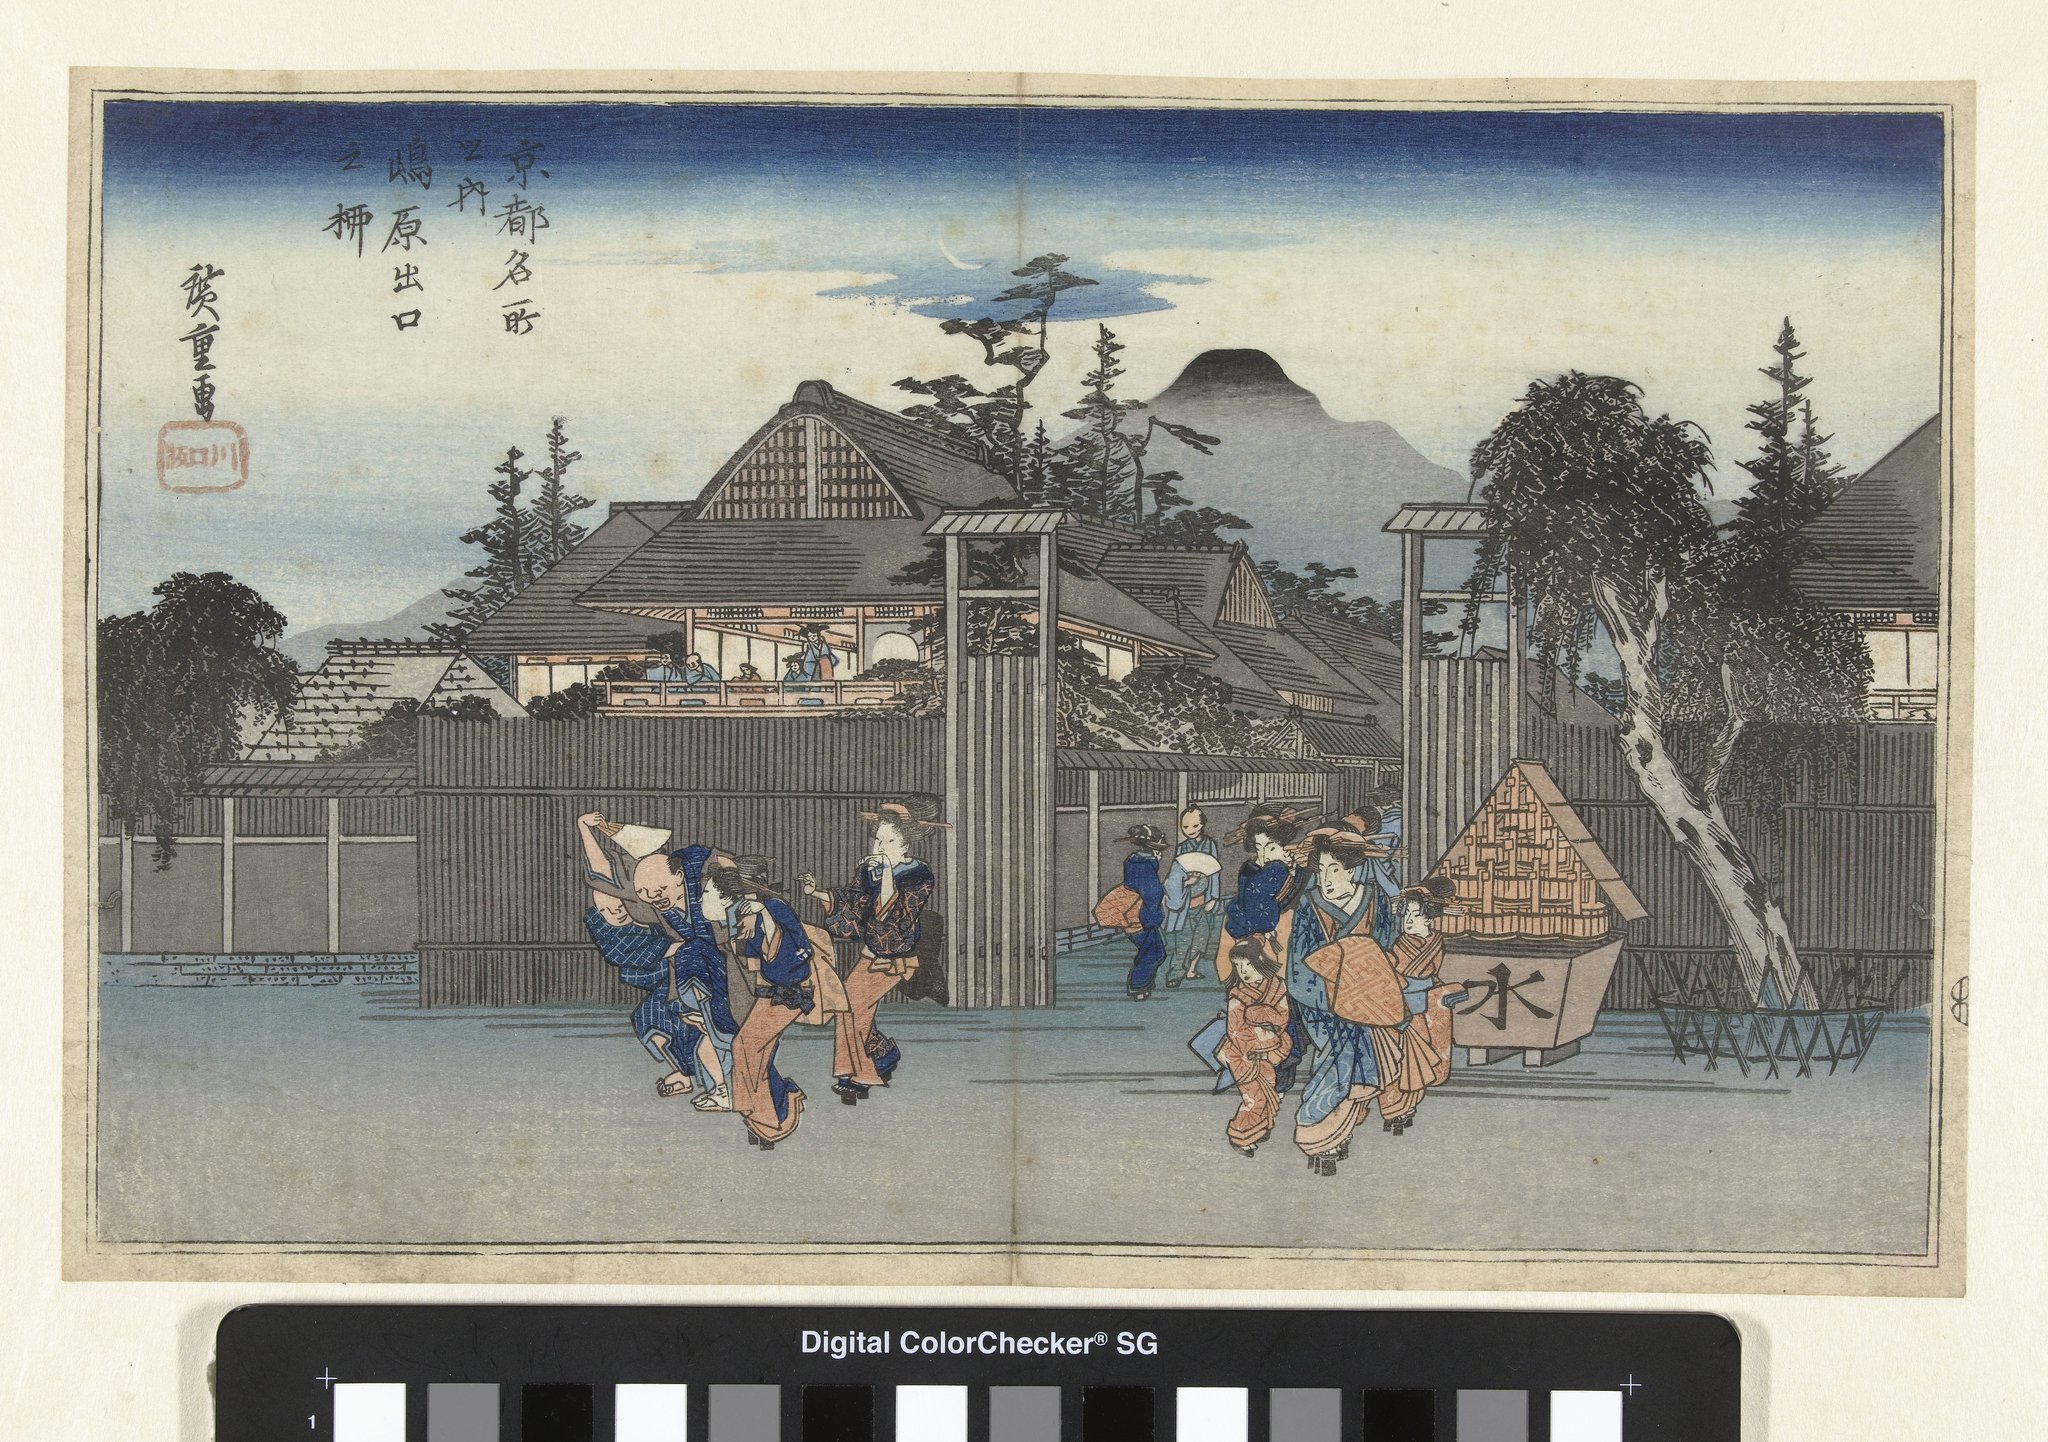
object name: print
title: Kyoto meisho no uchi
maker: utagawa hiroshige (i)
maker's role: draughtsman, print maker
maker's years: 1797-1858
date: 1832-1836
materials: paper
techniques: woodcut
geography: japan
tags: gate, entrance, courtesan, hetaera, drunkenness